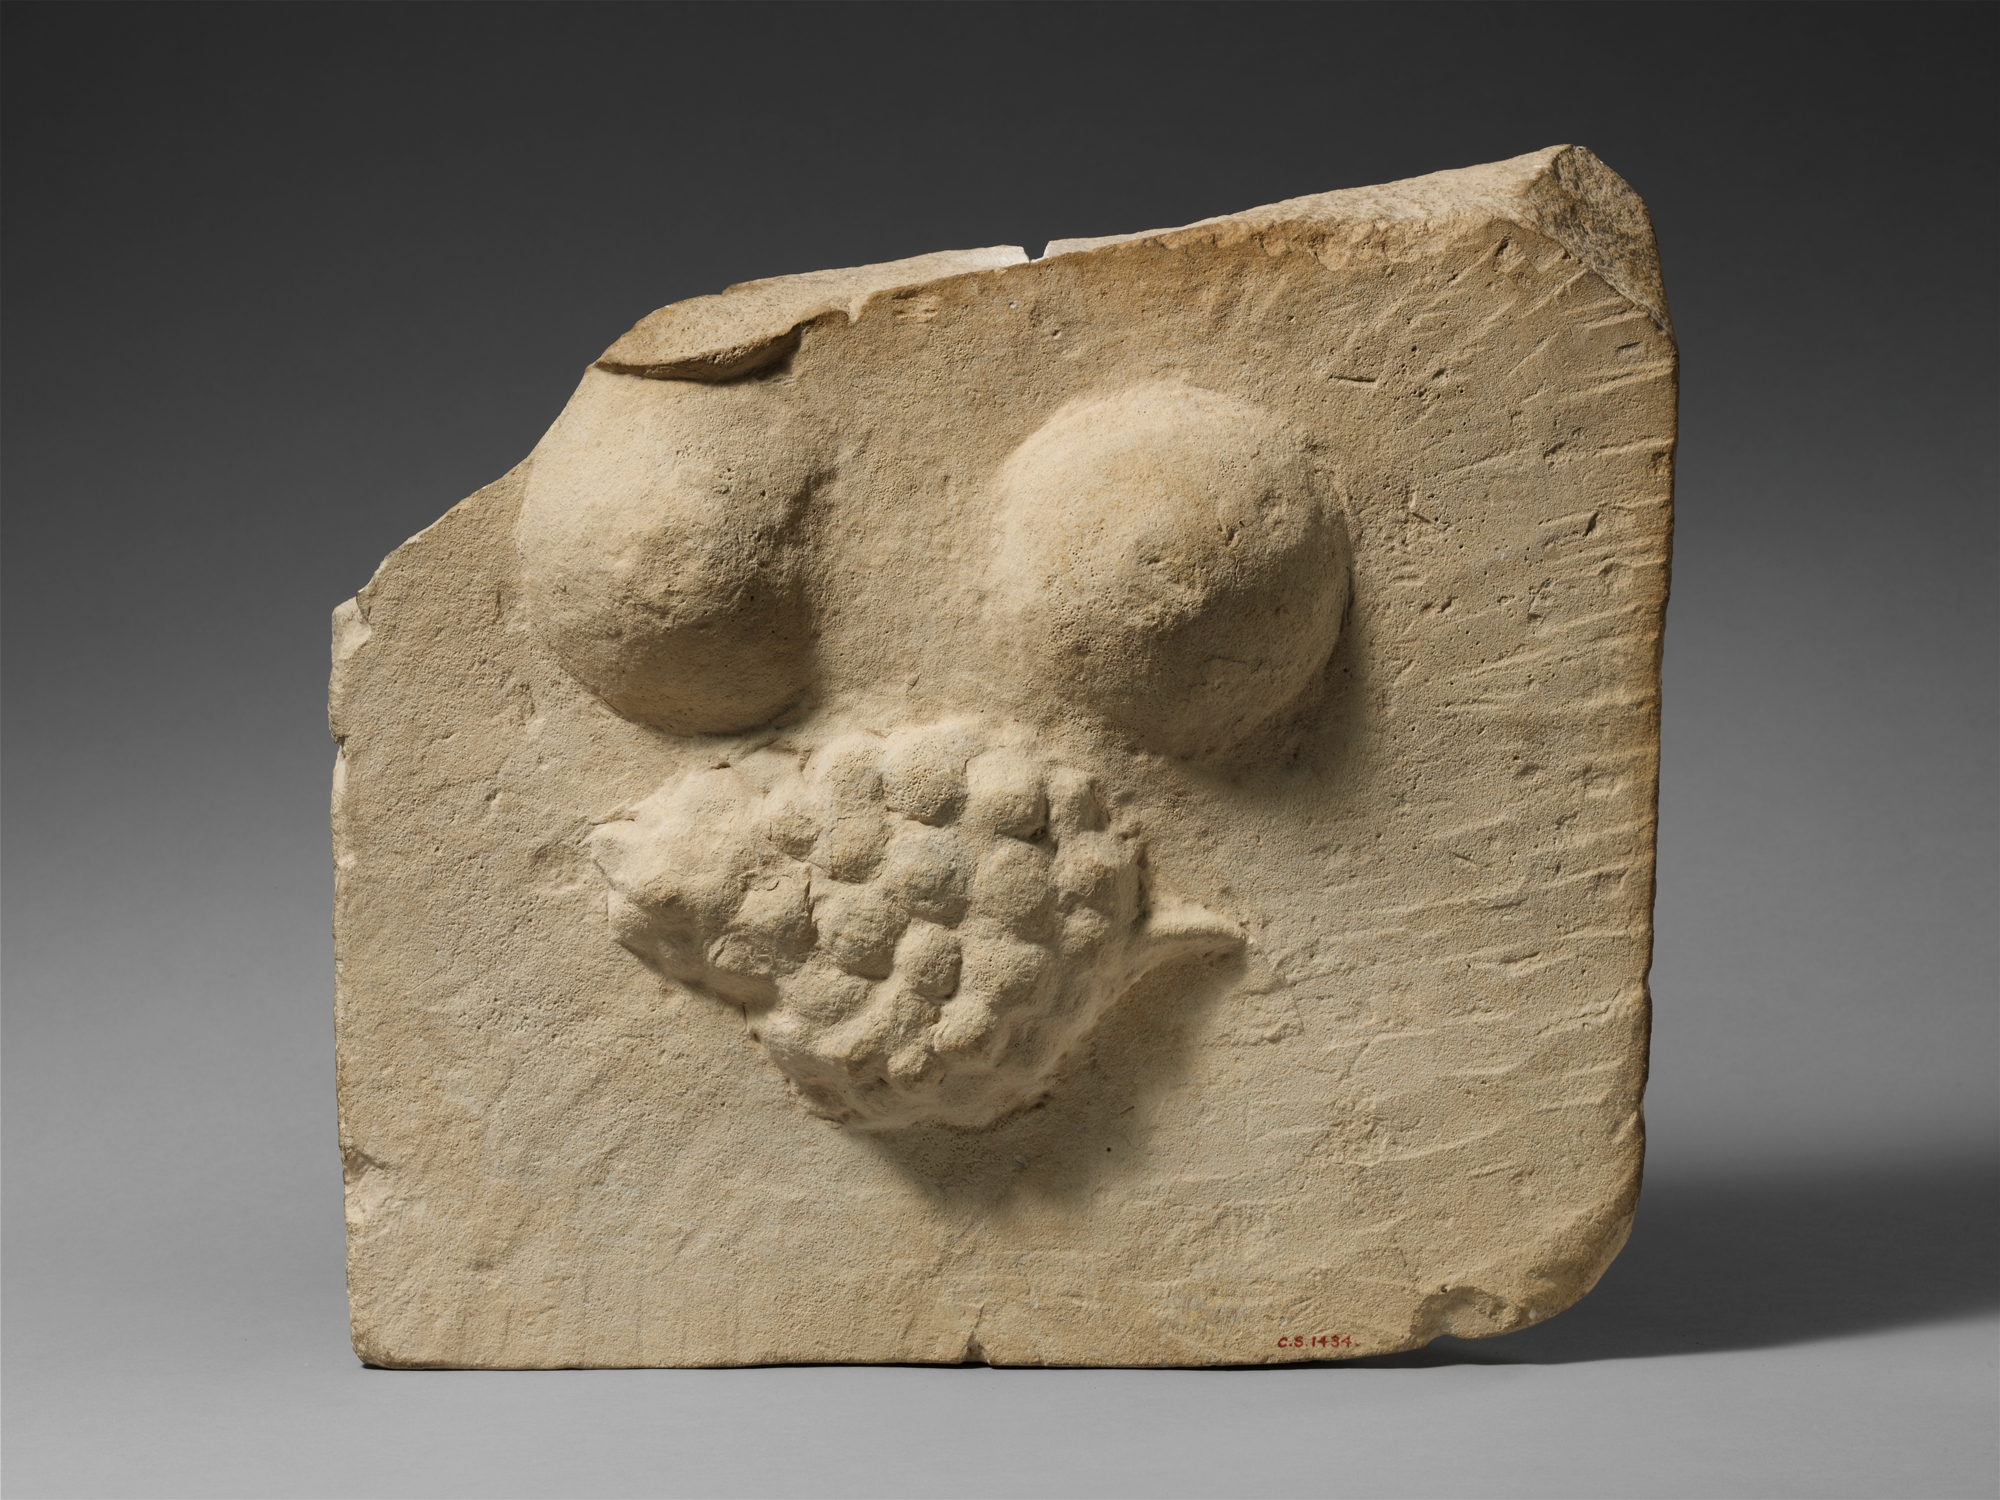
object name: relief of breast, votive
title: Limestone plaque with breasts and a bunch of grapes in relief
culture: cypriot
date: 350-250 BCE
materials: limestone